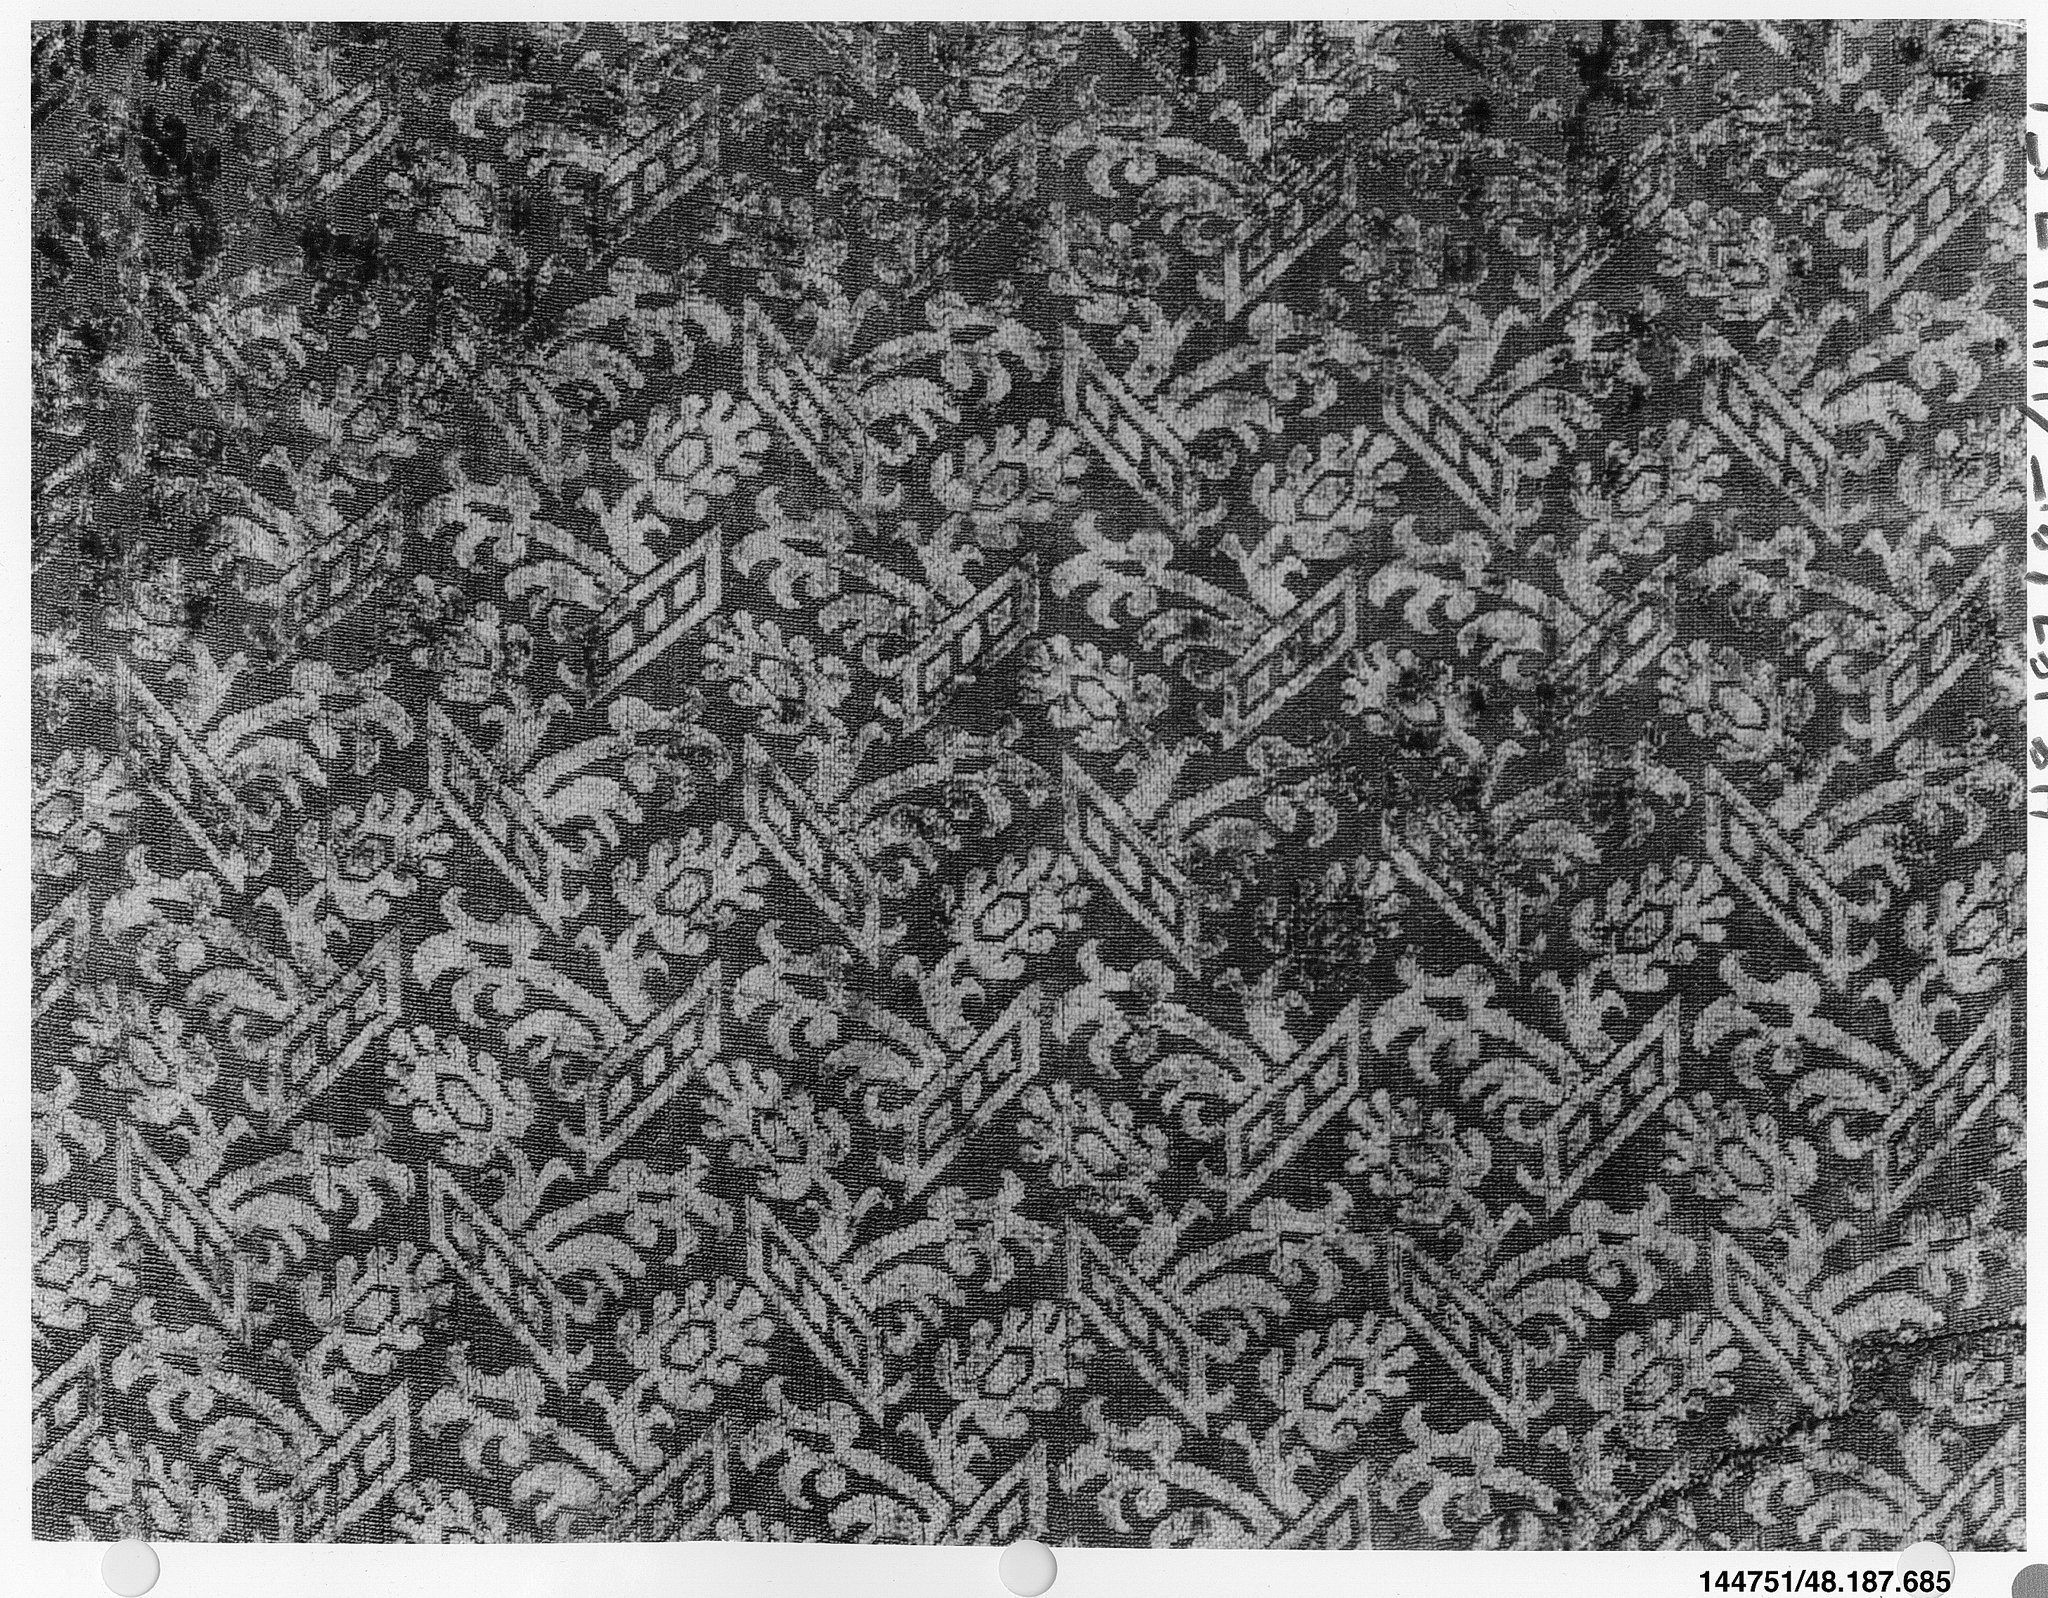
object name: piece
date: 1601-1700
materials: silk